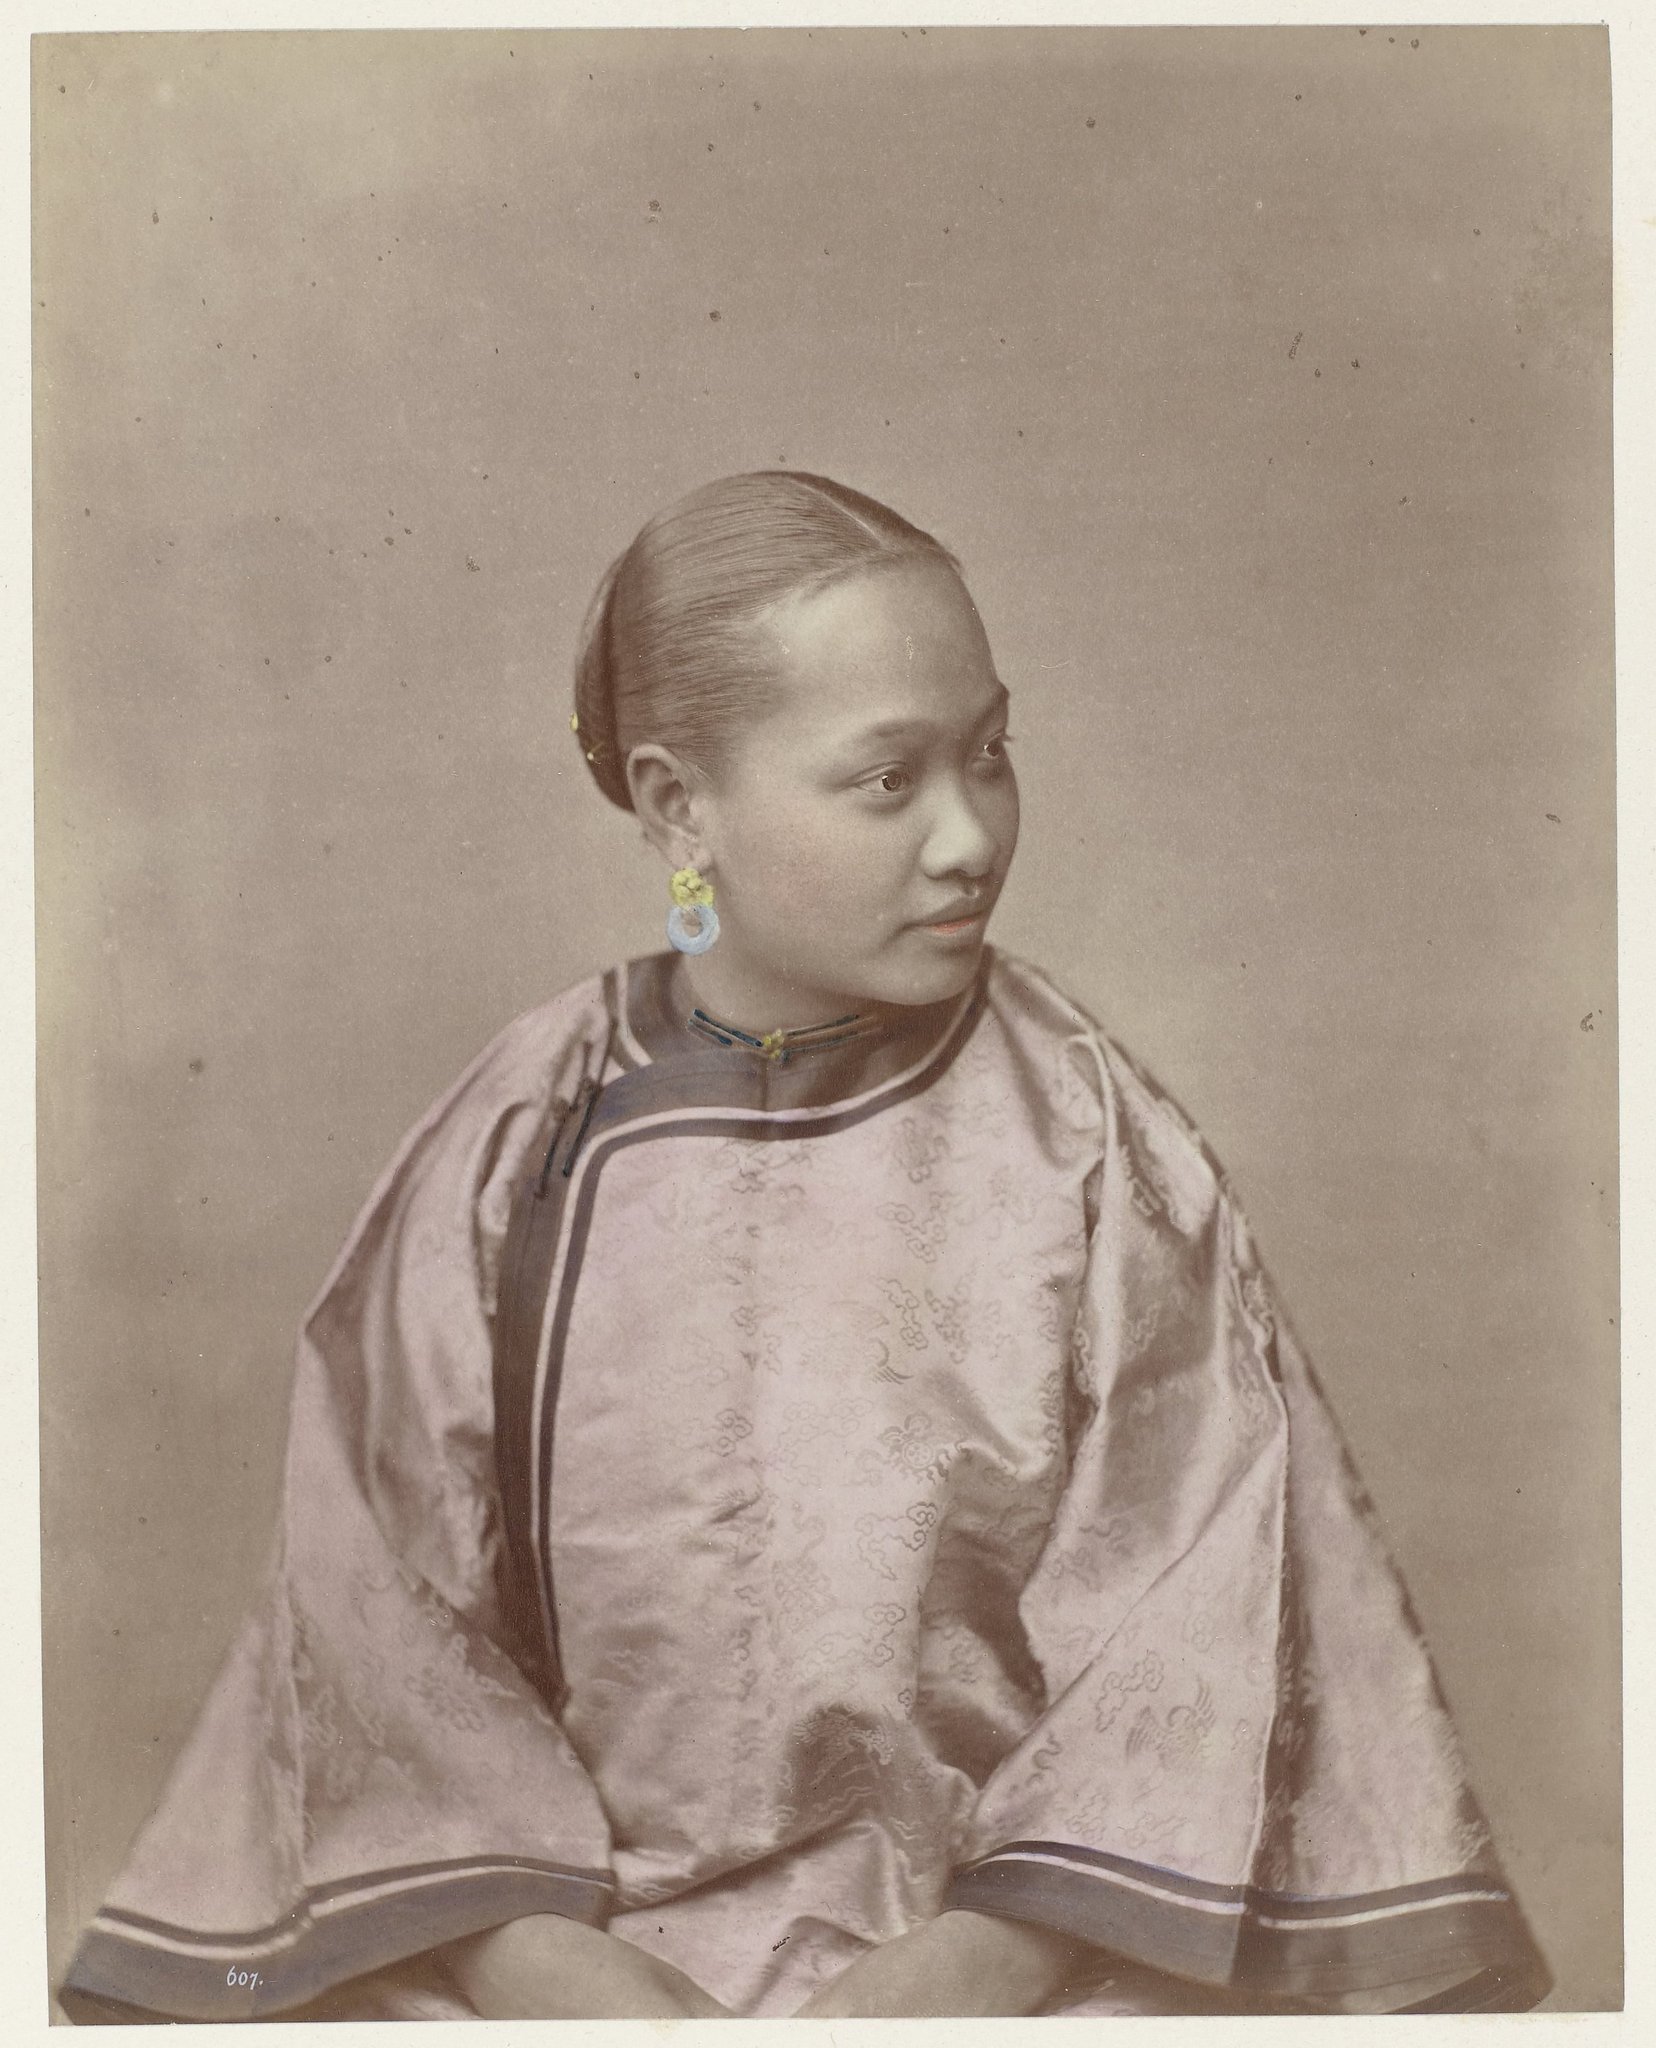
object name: photograph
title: Portret van een Chinese vrouw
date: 1860-1885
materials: cardboard, photographic support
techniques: albumen print, hand coloring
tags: adult woman, historical persons - bb - woman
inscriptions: number: ‘607’